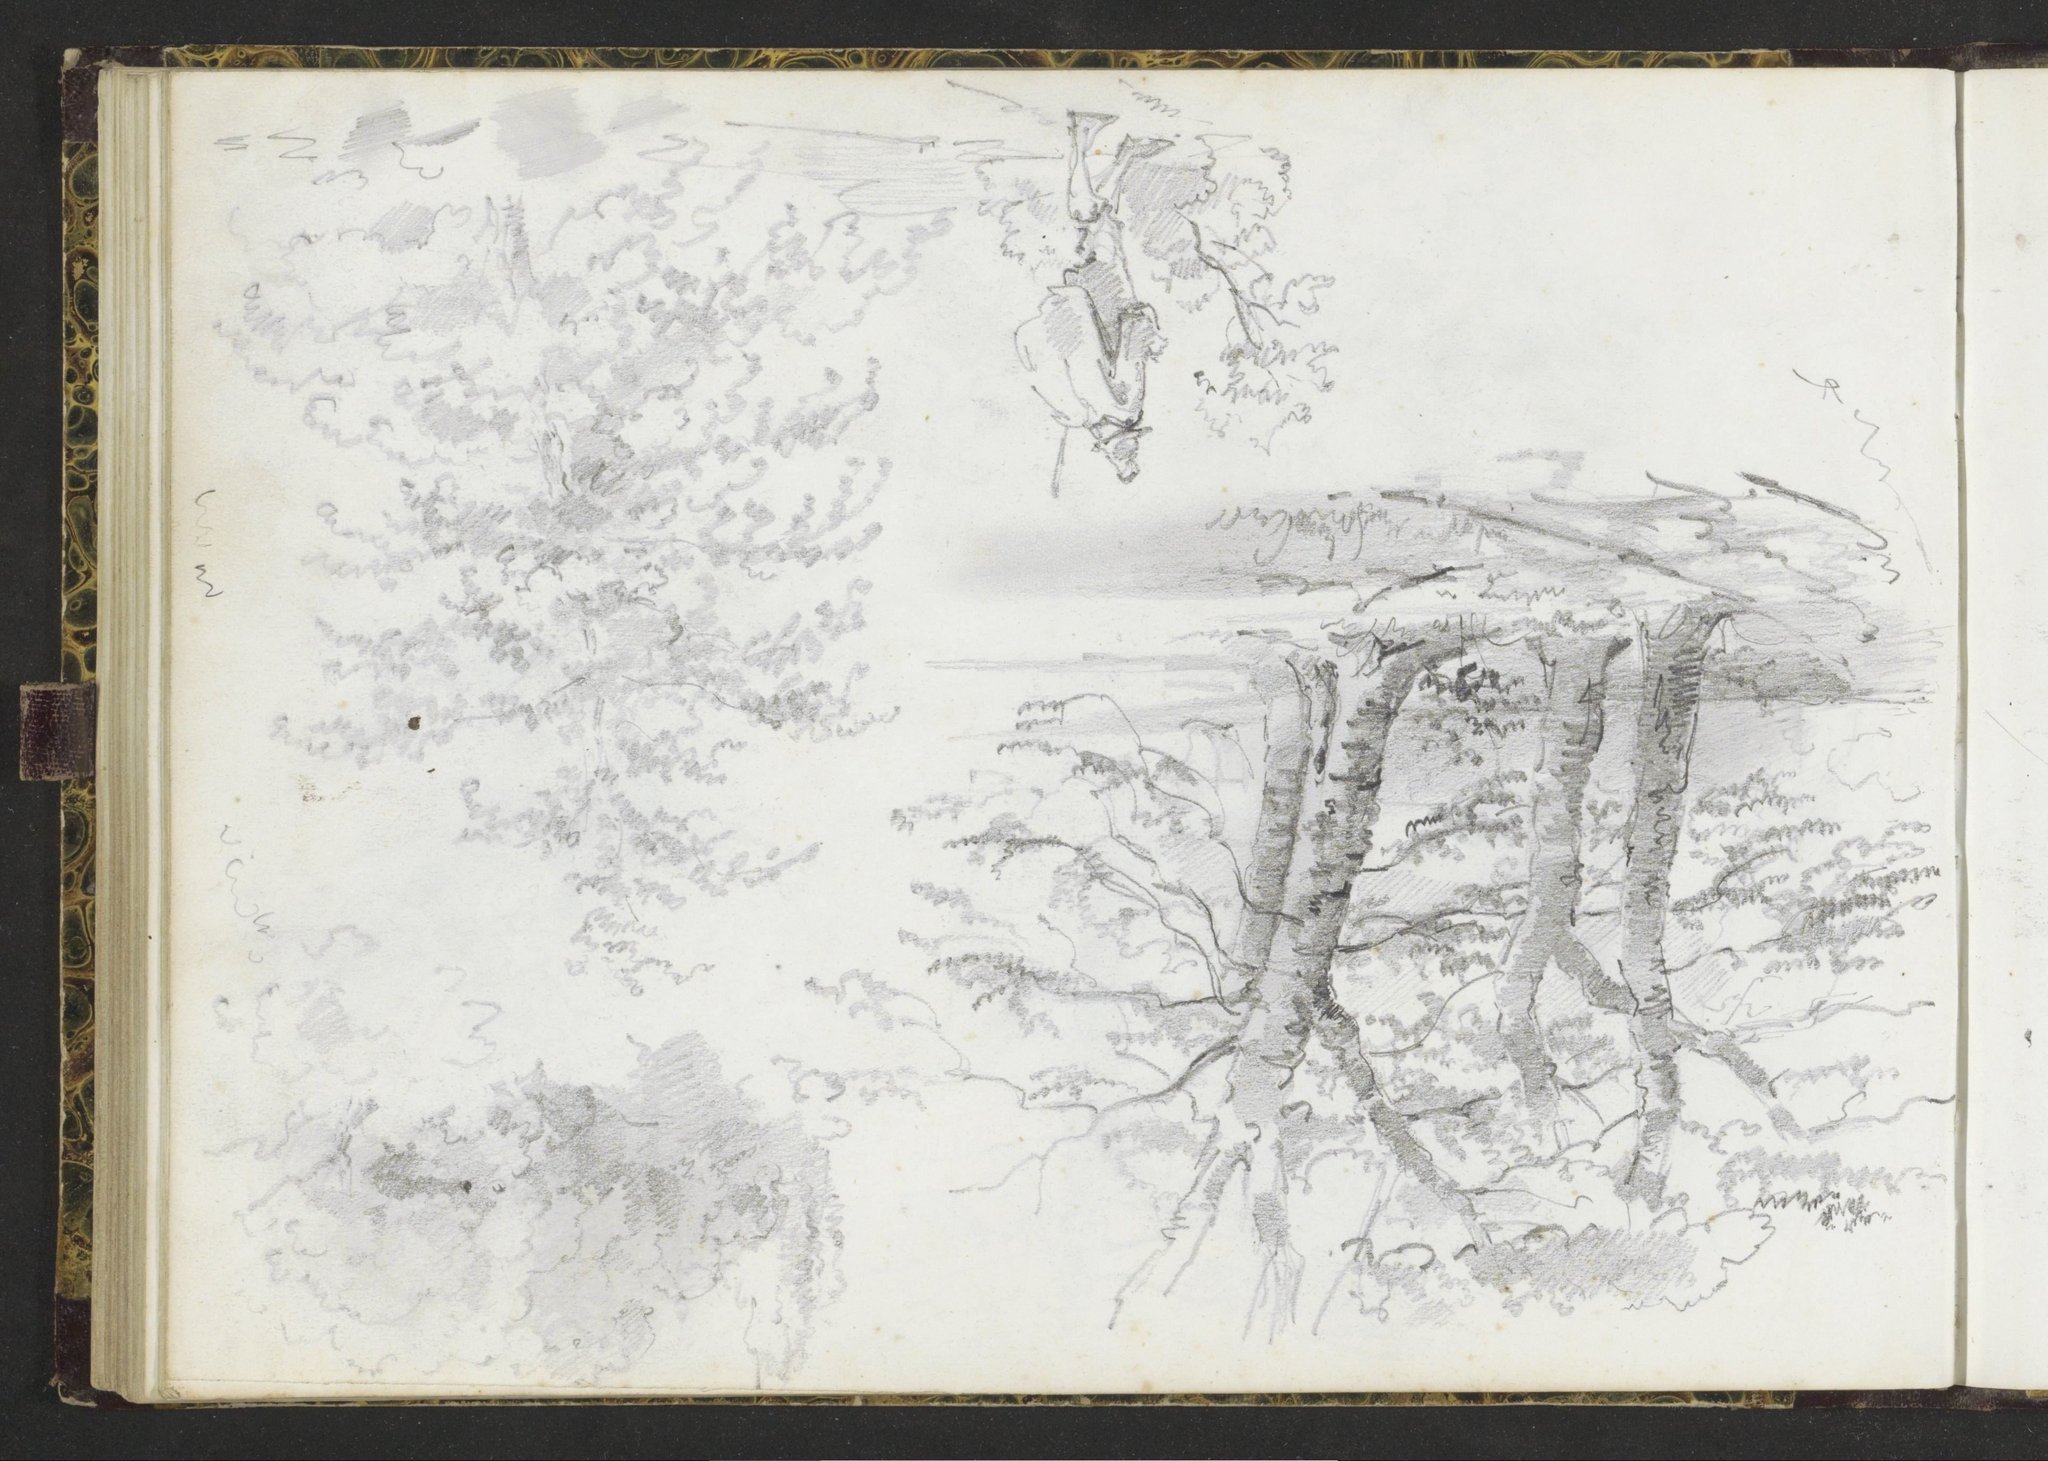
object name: sketchbook leaf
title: Studieblad met bomen en een wandelaar op een pad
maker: lambertus lingeman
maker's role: draughtsman, painter, print maker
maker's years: 1829-1894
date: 1839-1894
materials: paper, pencil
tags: trees, 'en route', traveller under way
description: Blad 50 verso uit een schetsboek met 51 bladen.